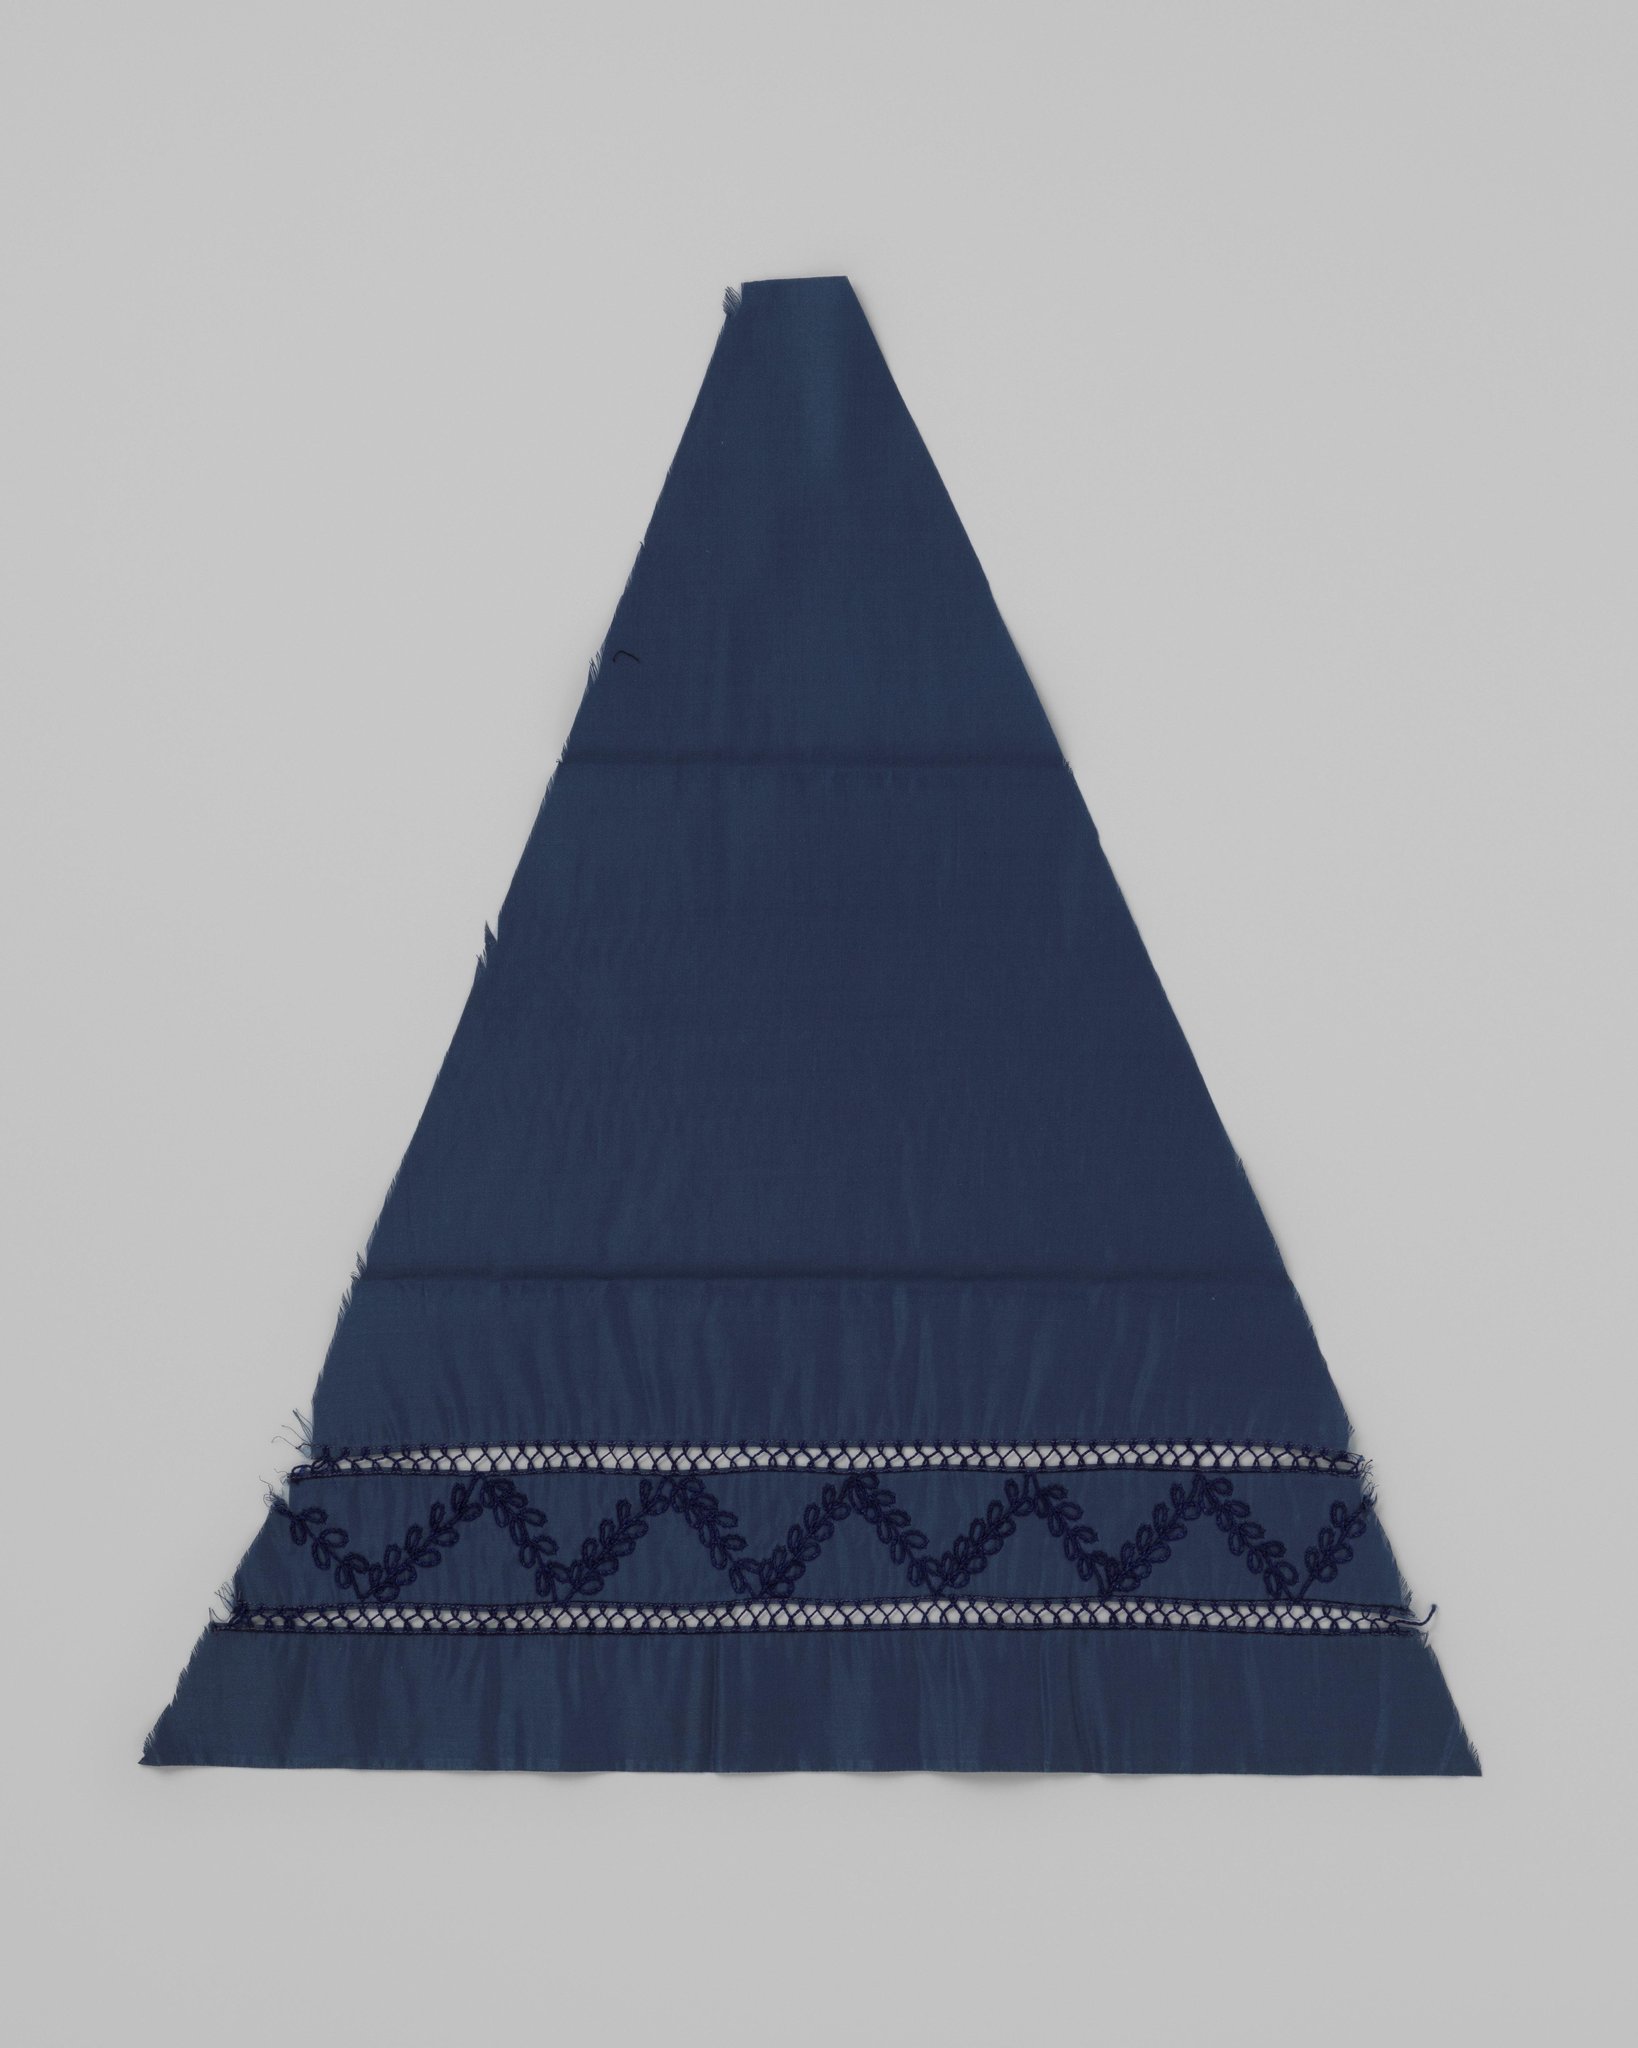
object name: parasoldek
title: Sector van een parasoldek van donkerblauwe katoen, versierd met borduurwerk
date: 1885-1900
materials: cotton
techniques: embroidered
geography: nijmegen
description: Sector van een parasoldek van donkerblauwe katoen, versierd met borduurwerk. Het borduurwerk bestaat uit twee rijen stiksteken doorgeregen met een flanelsteek, waartussen een slingerende bladrank. Aan het dek is een etiket bevestigd met een metalen klem.